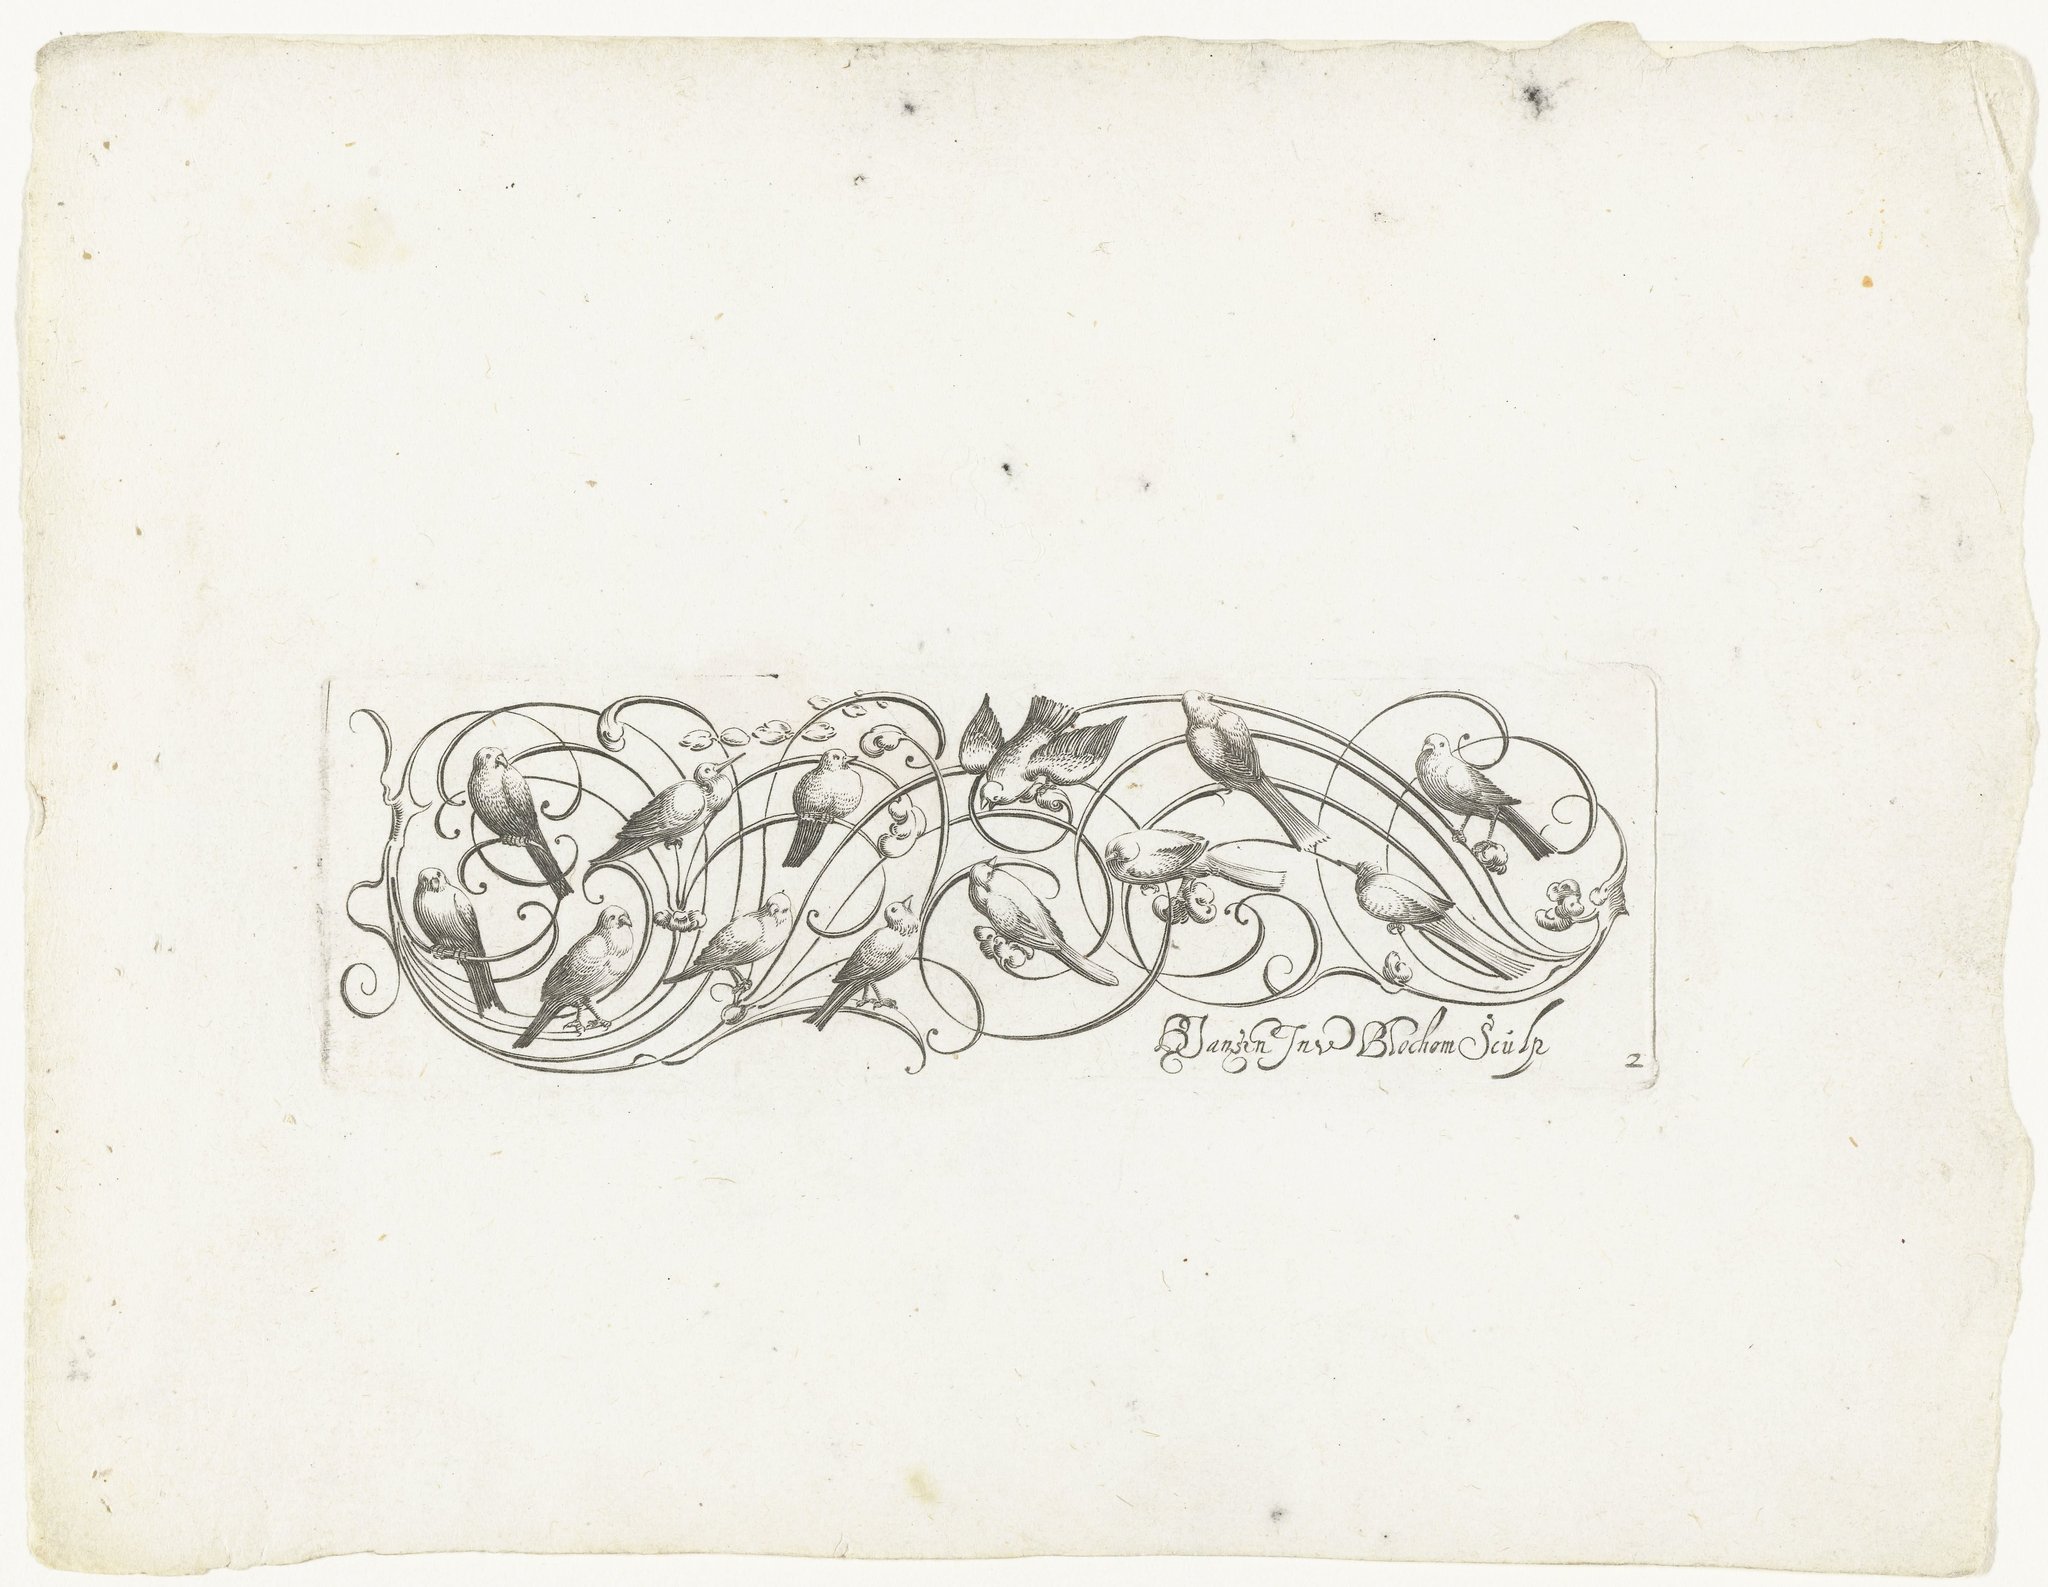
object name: print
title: Friezen met vogels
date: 1630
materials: paper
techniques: engraving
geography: amsterdam